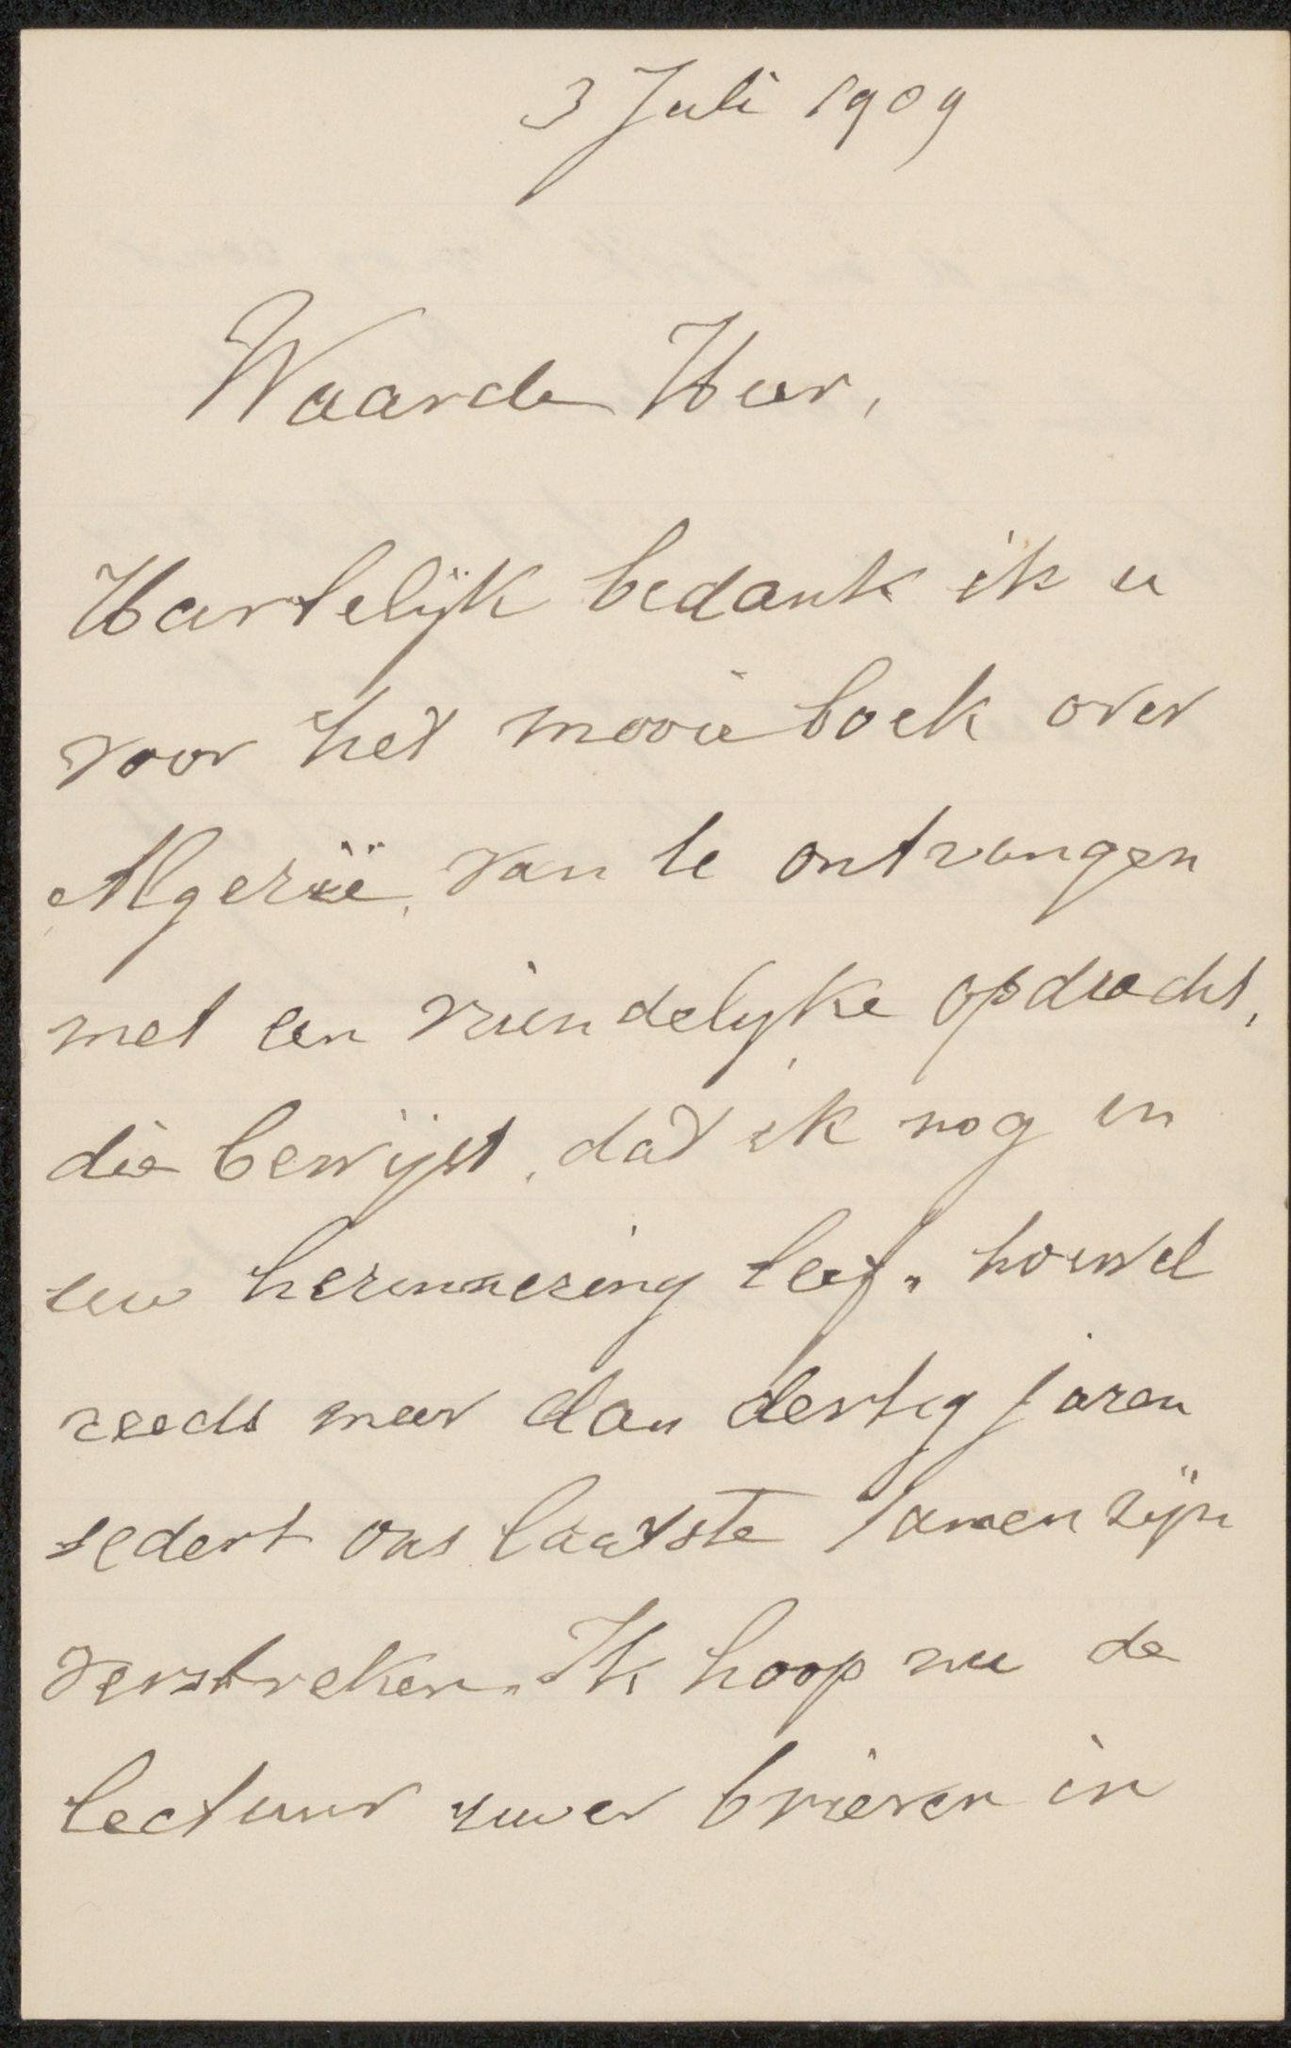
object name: letter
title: Brief aan Philip Zilcken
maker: frankamp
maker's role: leraar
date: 1909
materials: ink, paper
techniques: pen, writing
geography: the hague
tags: amsterdam, aegidius willem timmerman, the hague, painter, draughtsman, philip zilcken, venice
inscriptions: collector's mark: ‘RPK’